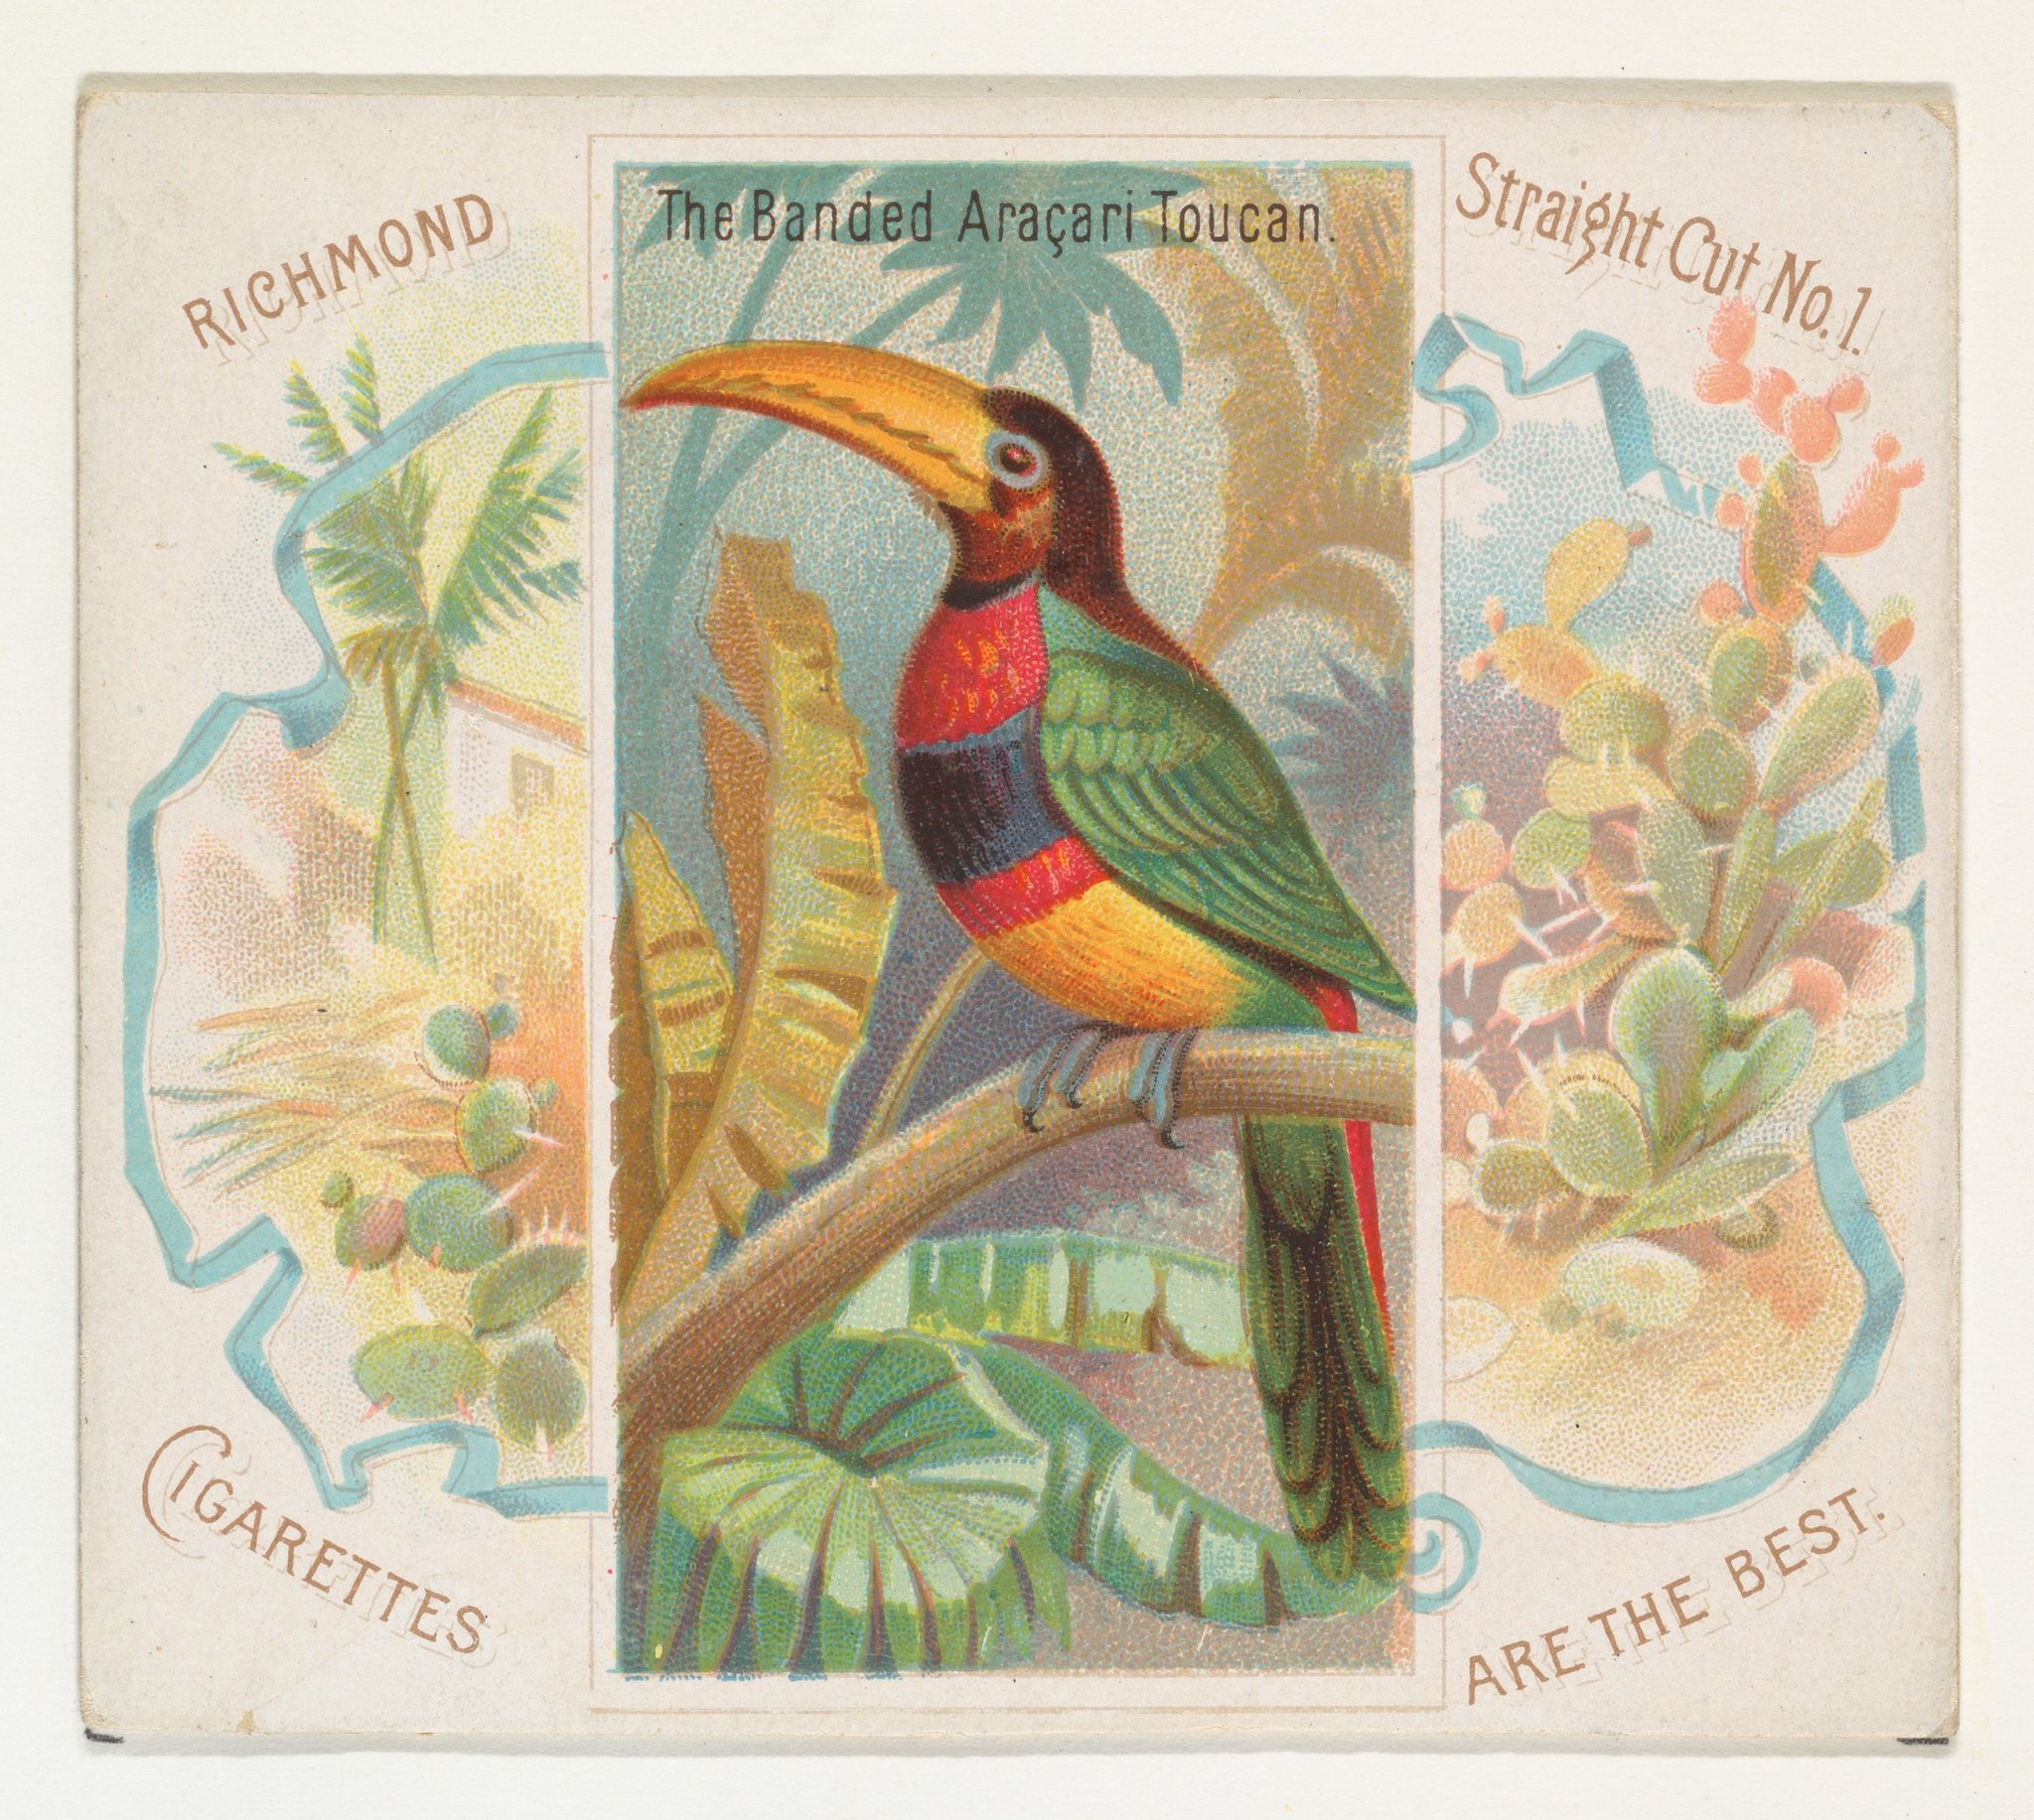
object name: print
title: The Banded Aracari Toucan, from Birds of the Tropics series (N38) for Allen & Ginter Cigarettes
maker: allen & ginter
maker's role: publisher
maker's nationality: american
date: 1889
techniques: color lithograph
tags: birds